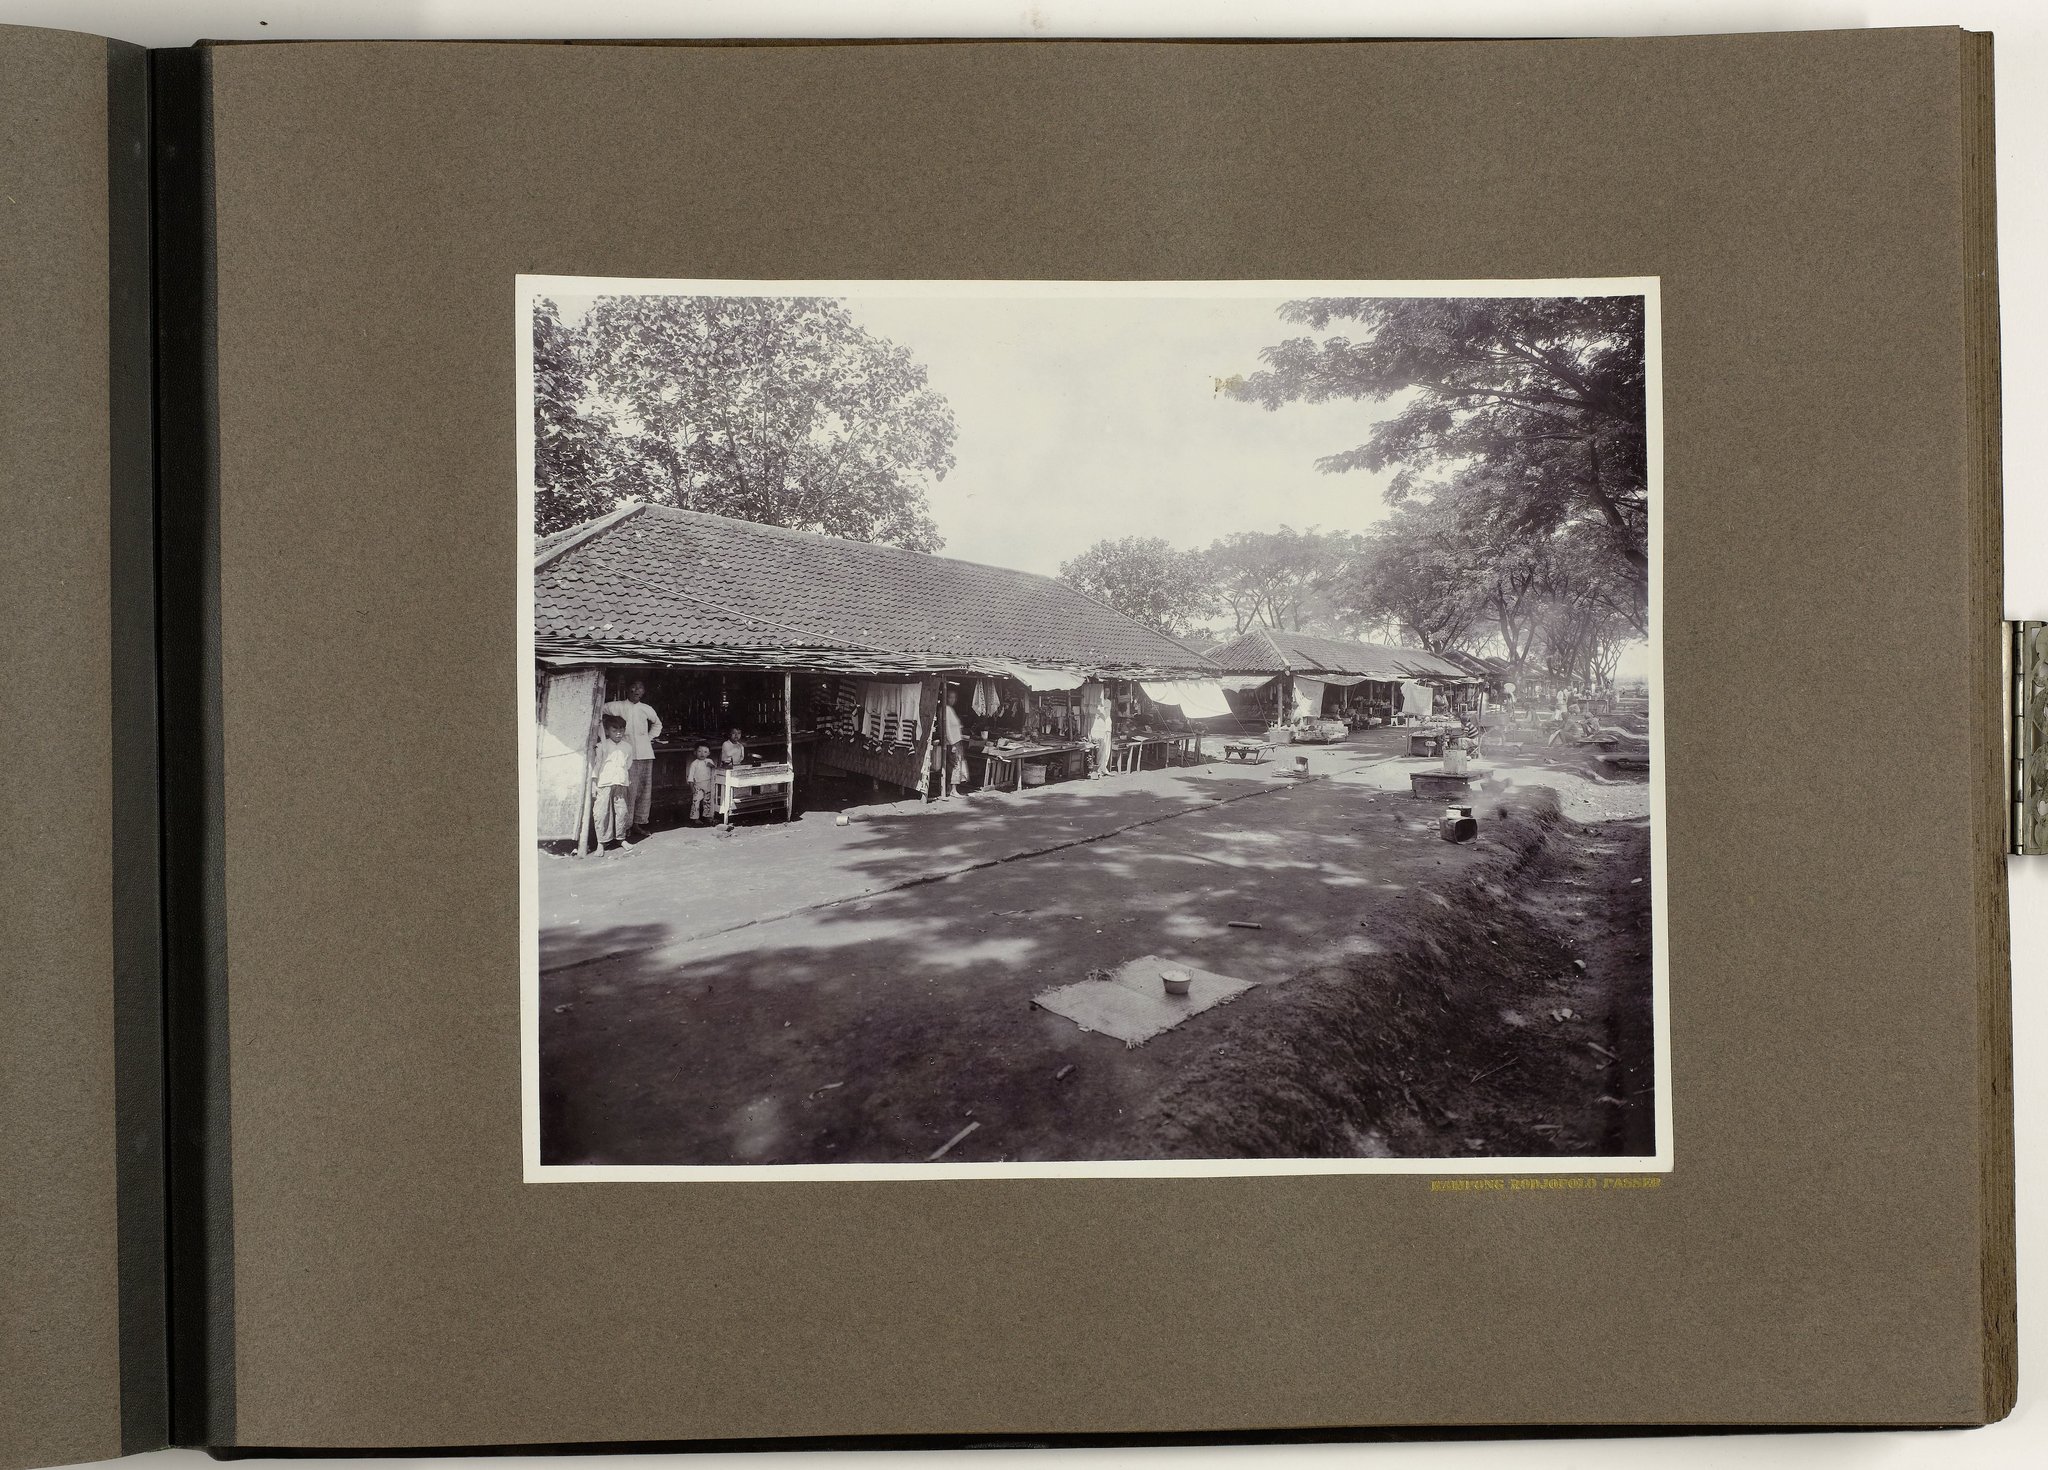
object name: photograph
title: Kampong Rodjopolo Passer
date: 1917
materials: photographic support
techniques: gelatin silver print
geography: jatiroto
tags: colonial system, (non-fruit) products of plants or trees: sugarcane, rural housing, e.g. country-house, villa, cottage, public road in village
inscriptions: inscription: ‘KAMPONG RODJOPOLO PASSER’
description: Marktstallen in het dorp Rodjopolo (Rojopolo). Onderdeel van het fotoalbum aangeboden aan F.J. Wirix door het personeel van de Suikeronderneming Djatiroto in 1917.